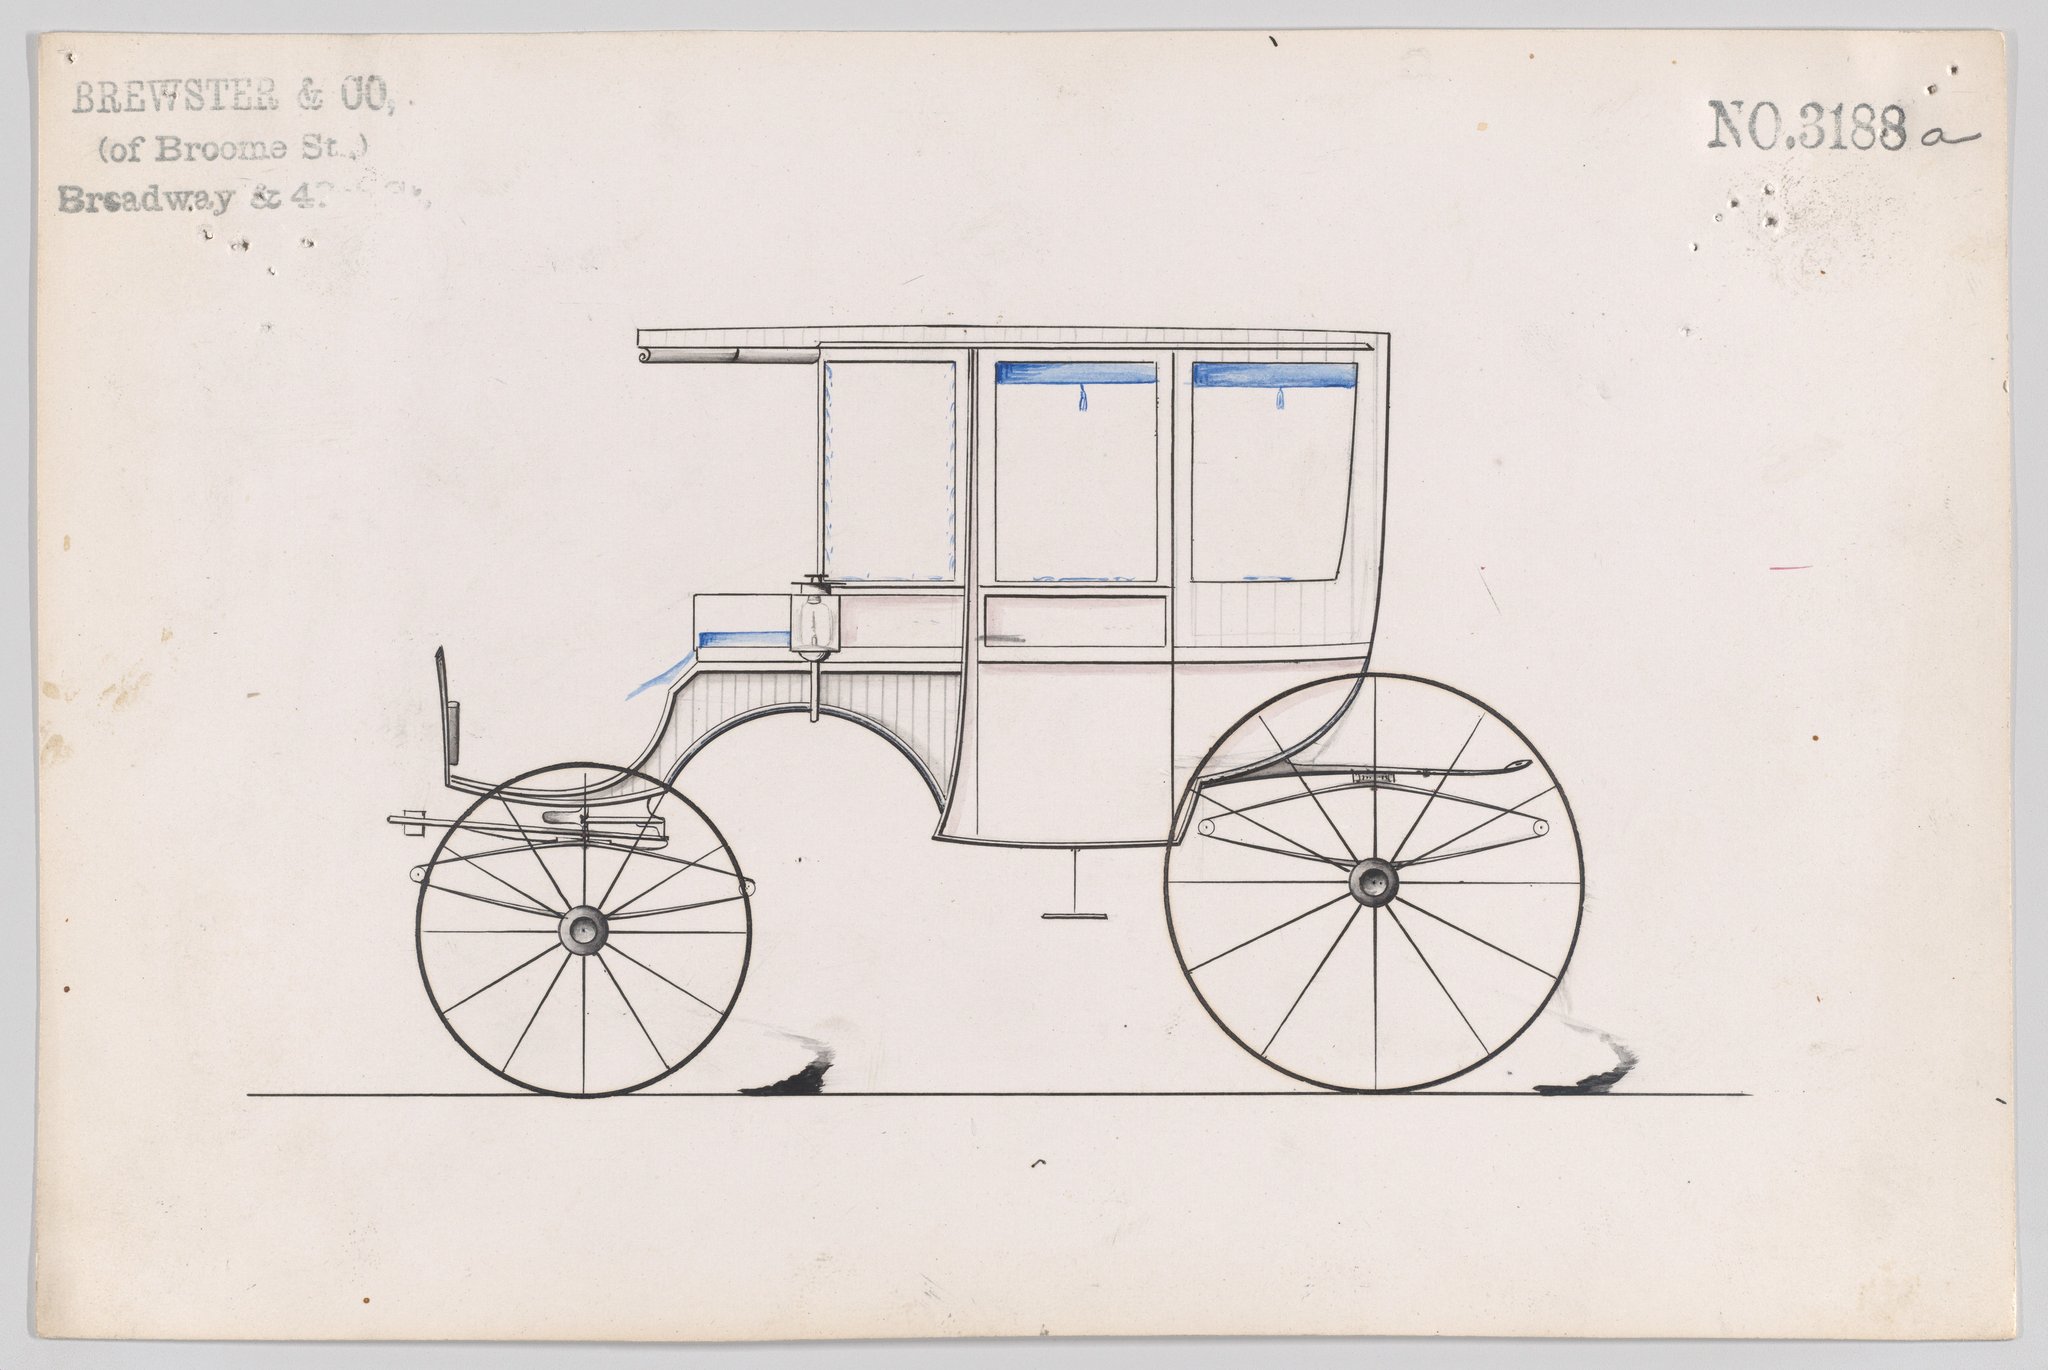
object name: drawing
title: Design for 6 seat Rockaway, no. 3188a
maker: brewster & co.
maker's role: manufacturer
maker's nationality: american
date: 1876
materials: gouache, ink, watercolor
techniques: pen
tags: carriages